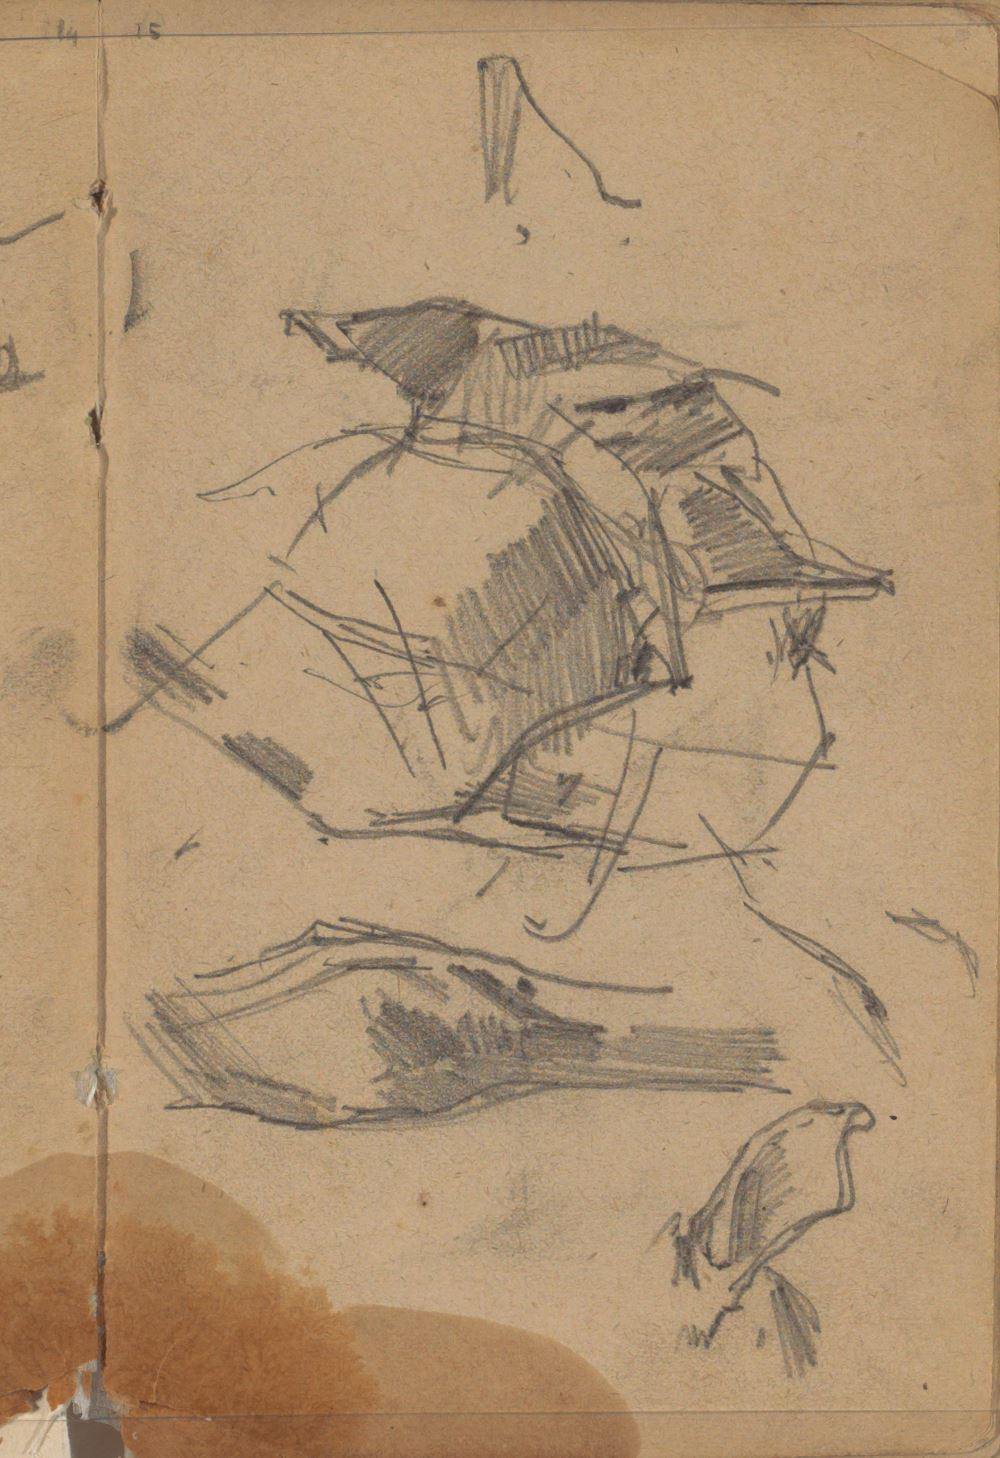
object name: sketchbook leaf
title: Studieblad met dieren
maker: george hendrik breitner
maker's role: draughtsman, painter, print maker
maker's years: 1857-1923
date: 1881-1883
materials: paper, pencil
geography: south holland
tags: animals, dog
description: Studieblad met dieren, waaronder mogelijk een hondenkop. Pagina 15 uit een schetsboek met 70 bladen.